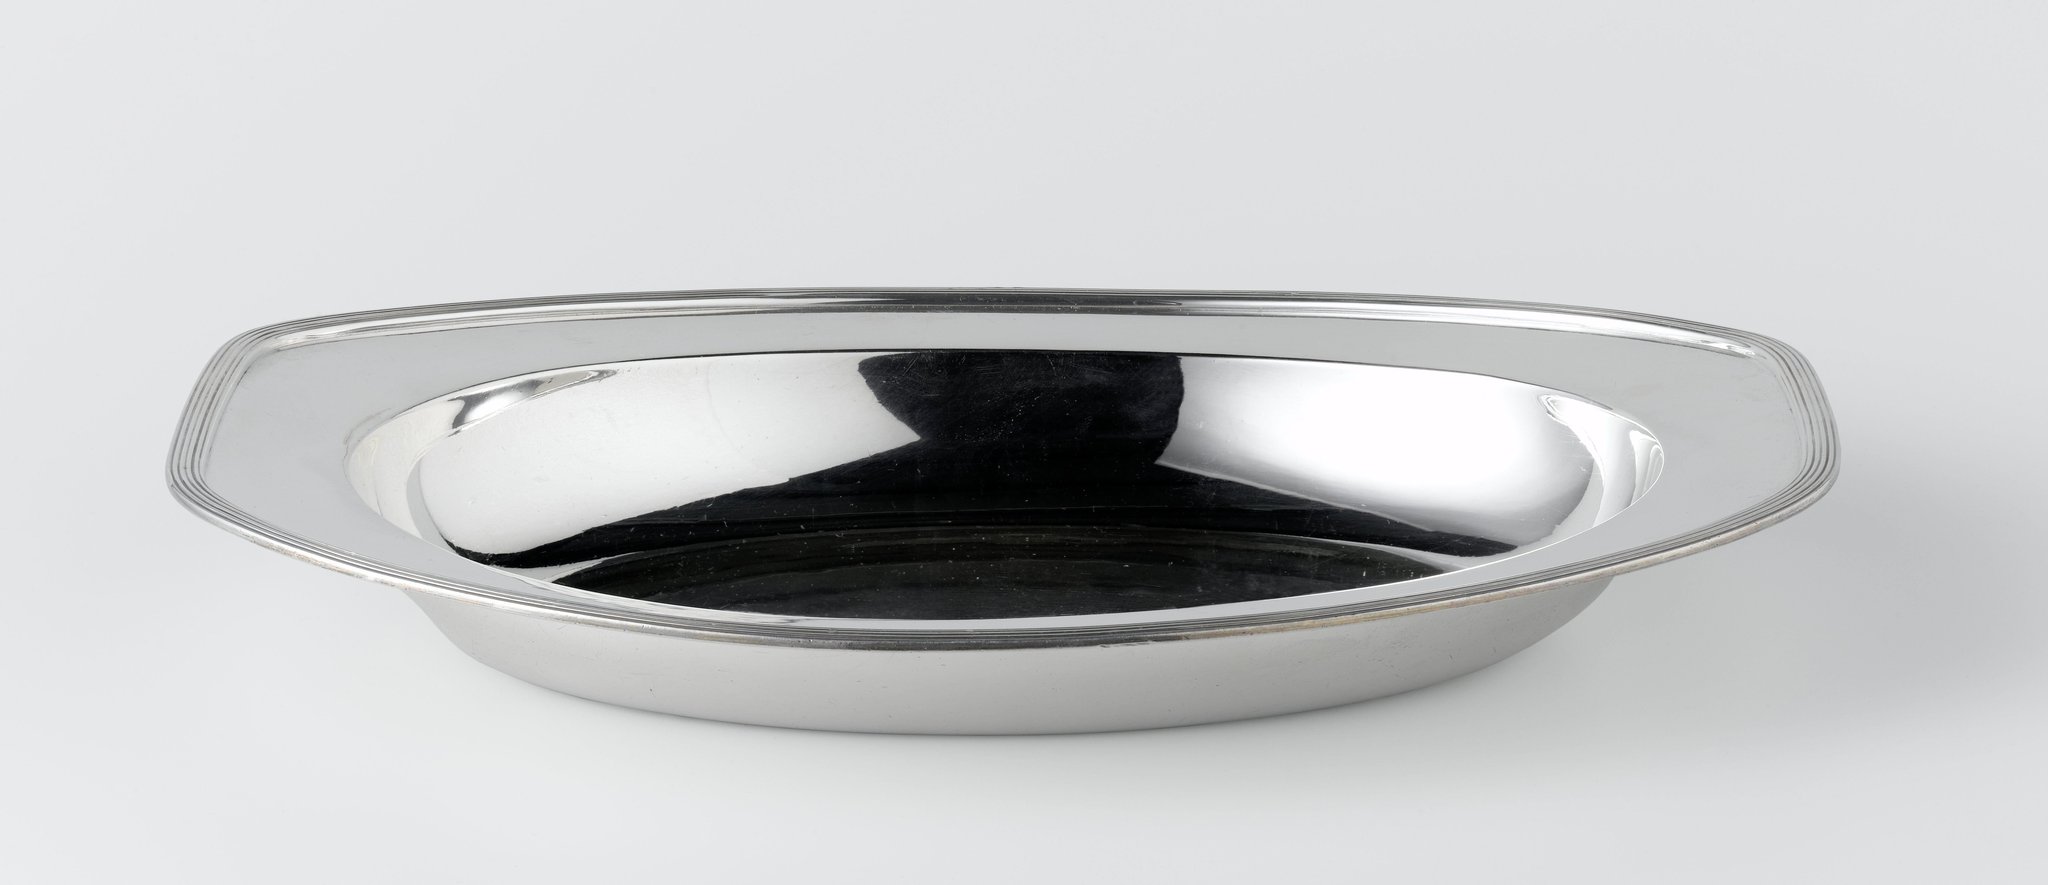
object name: vessel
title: Parts of the Silver Dinner Service for the Prince of Orange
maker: jacob hendrik stellingwerff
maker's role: silversmith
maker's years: 1773-1823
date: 1816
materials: silver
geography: amsterdam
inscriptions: retailer's mark: ‘BENNEWITZ BONEBAKKER’, date letter: ‘G’, maker's mark, duty mark: ‘I’, assay office mark, assayer's mark: ‘S1 in ovaal’, alloy mark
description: William Prince of Orange (later William II) and the Russian grand duchess Anna Pavlovna were married in St Petersburg in 1816. Back in the Netherlands, they were showered with wedding gifts. The City of Amsterdam commissioned a 419-piece silver dinner service, a small part of which is on view here. The House of Orange family coat of arms features the Dutch lion. Most appropriately, the handles of the soup tureen are in the shape of lion heads.